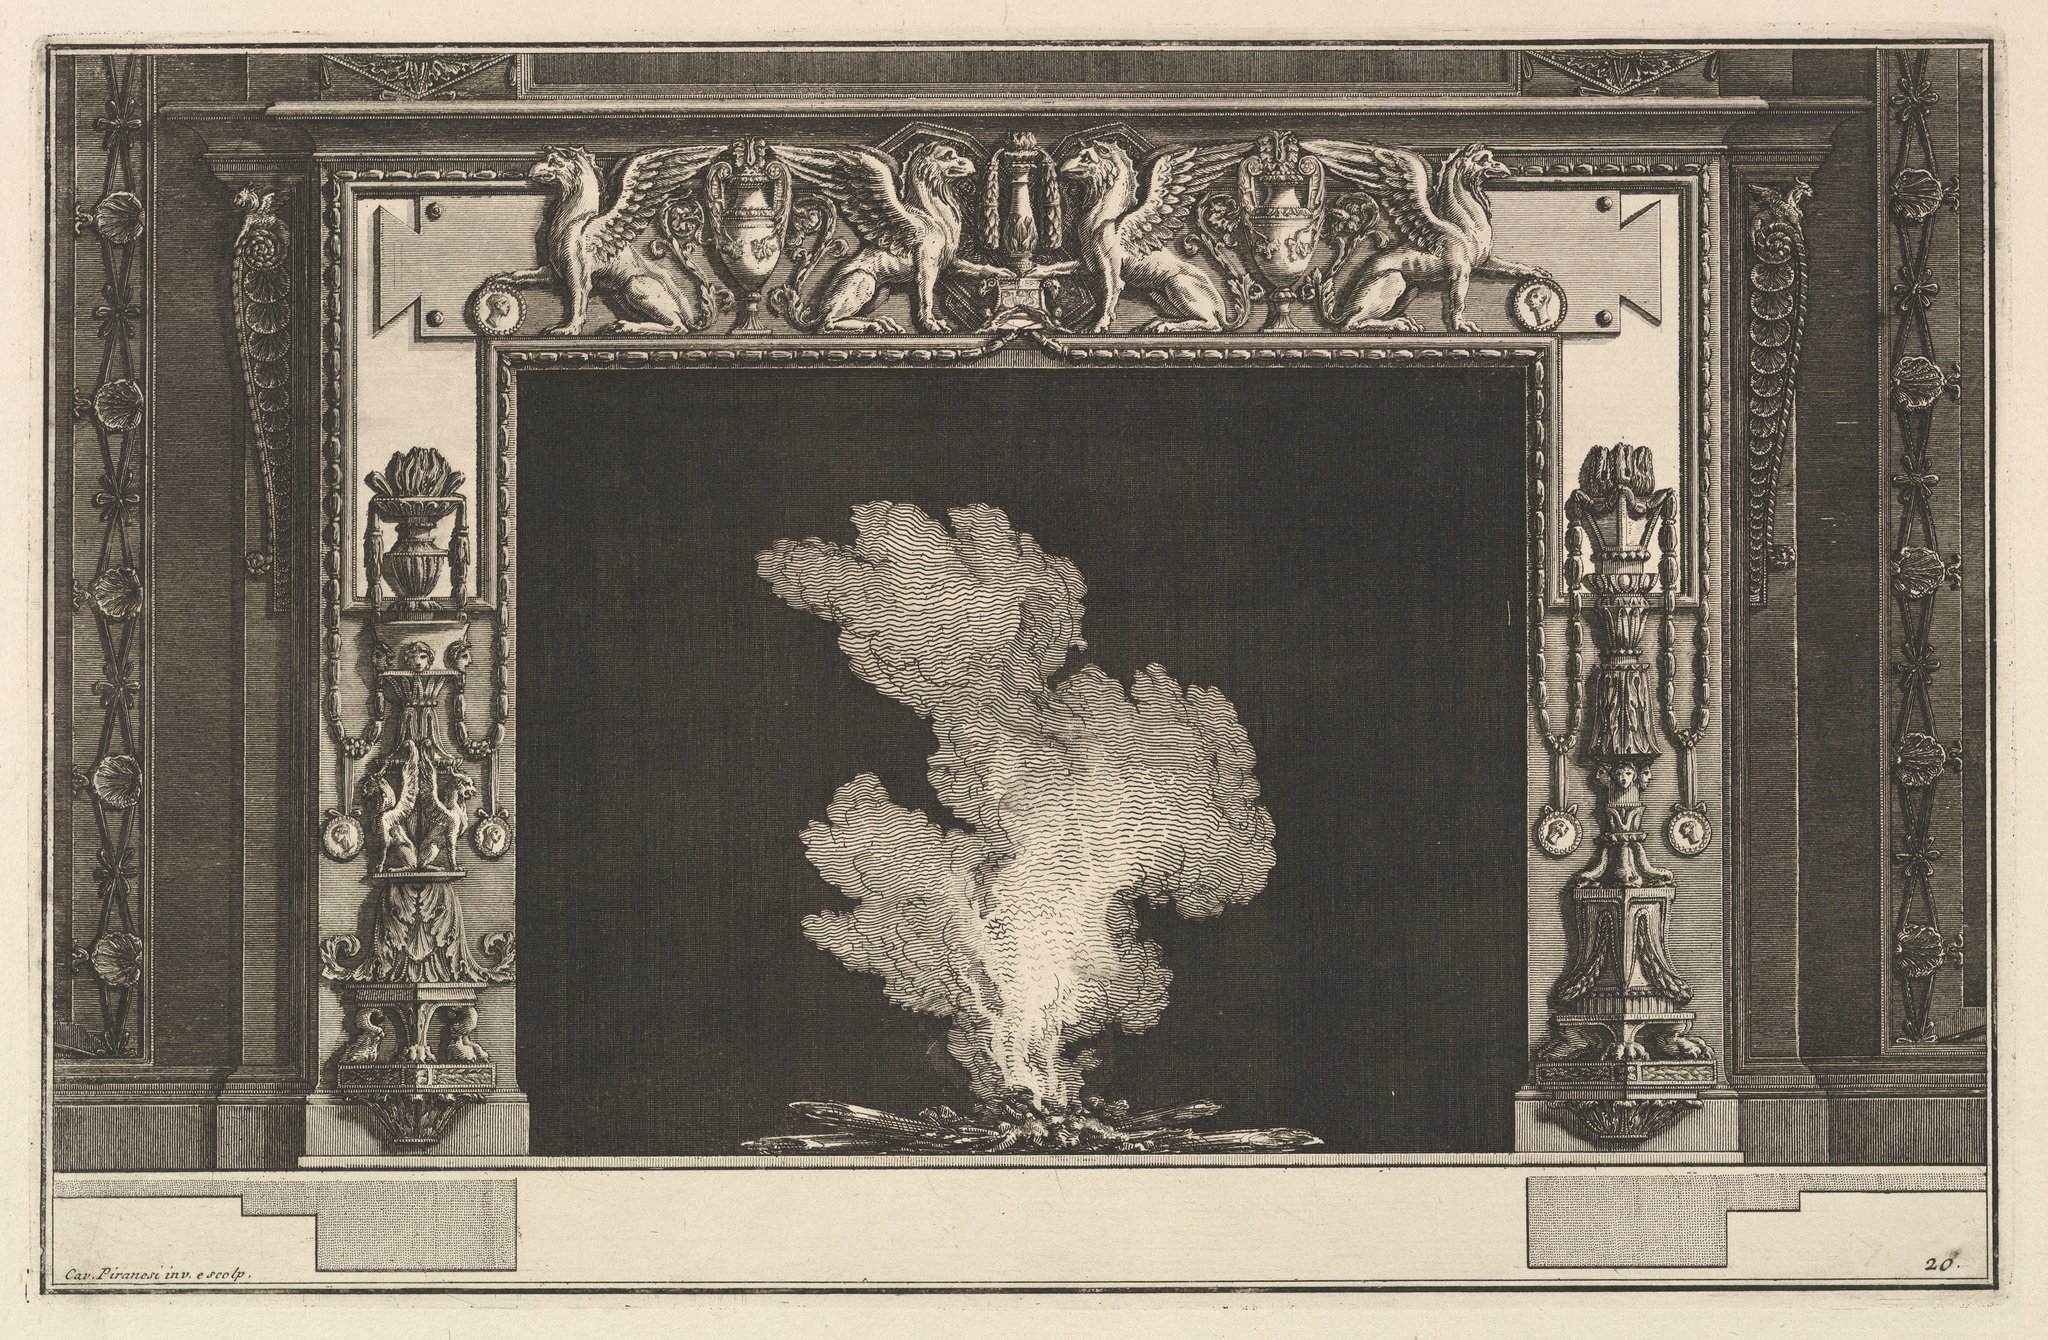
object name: print ornament architecture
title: Chimneypiece: Affronted griffons on the lintel and candelabra on the jambs (Ch. accompagnée de son plan et décorée d'une frise de griffons), from Diverse Maniere d'adornare i cammini ed ogni altra parte degli edifizi...(Different Ways of ornamenting chimneypieces and all other parts of houses)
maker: giovanni battista piranesi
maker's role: artist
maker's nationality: italian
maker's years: 1720-1778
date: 1769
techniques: etching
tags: fireplaces,griffins,fire